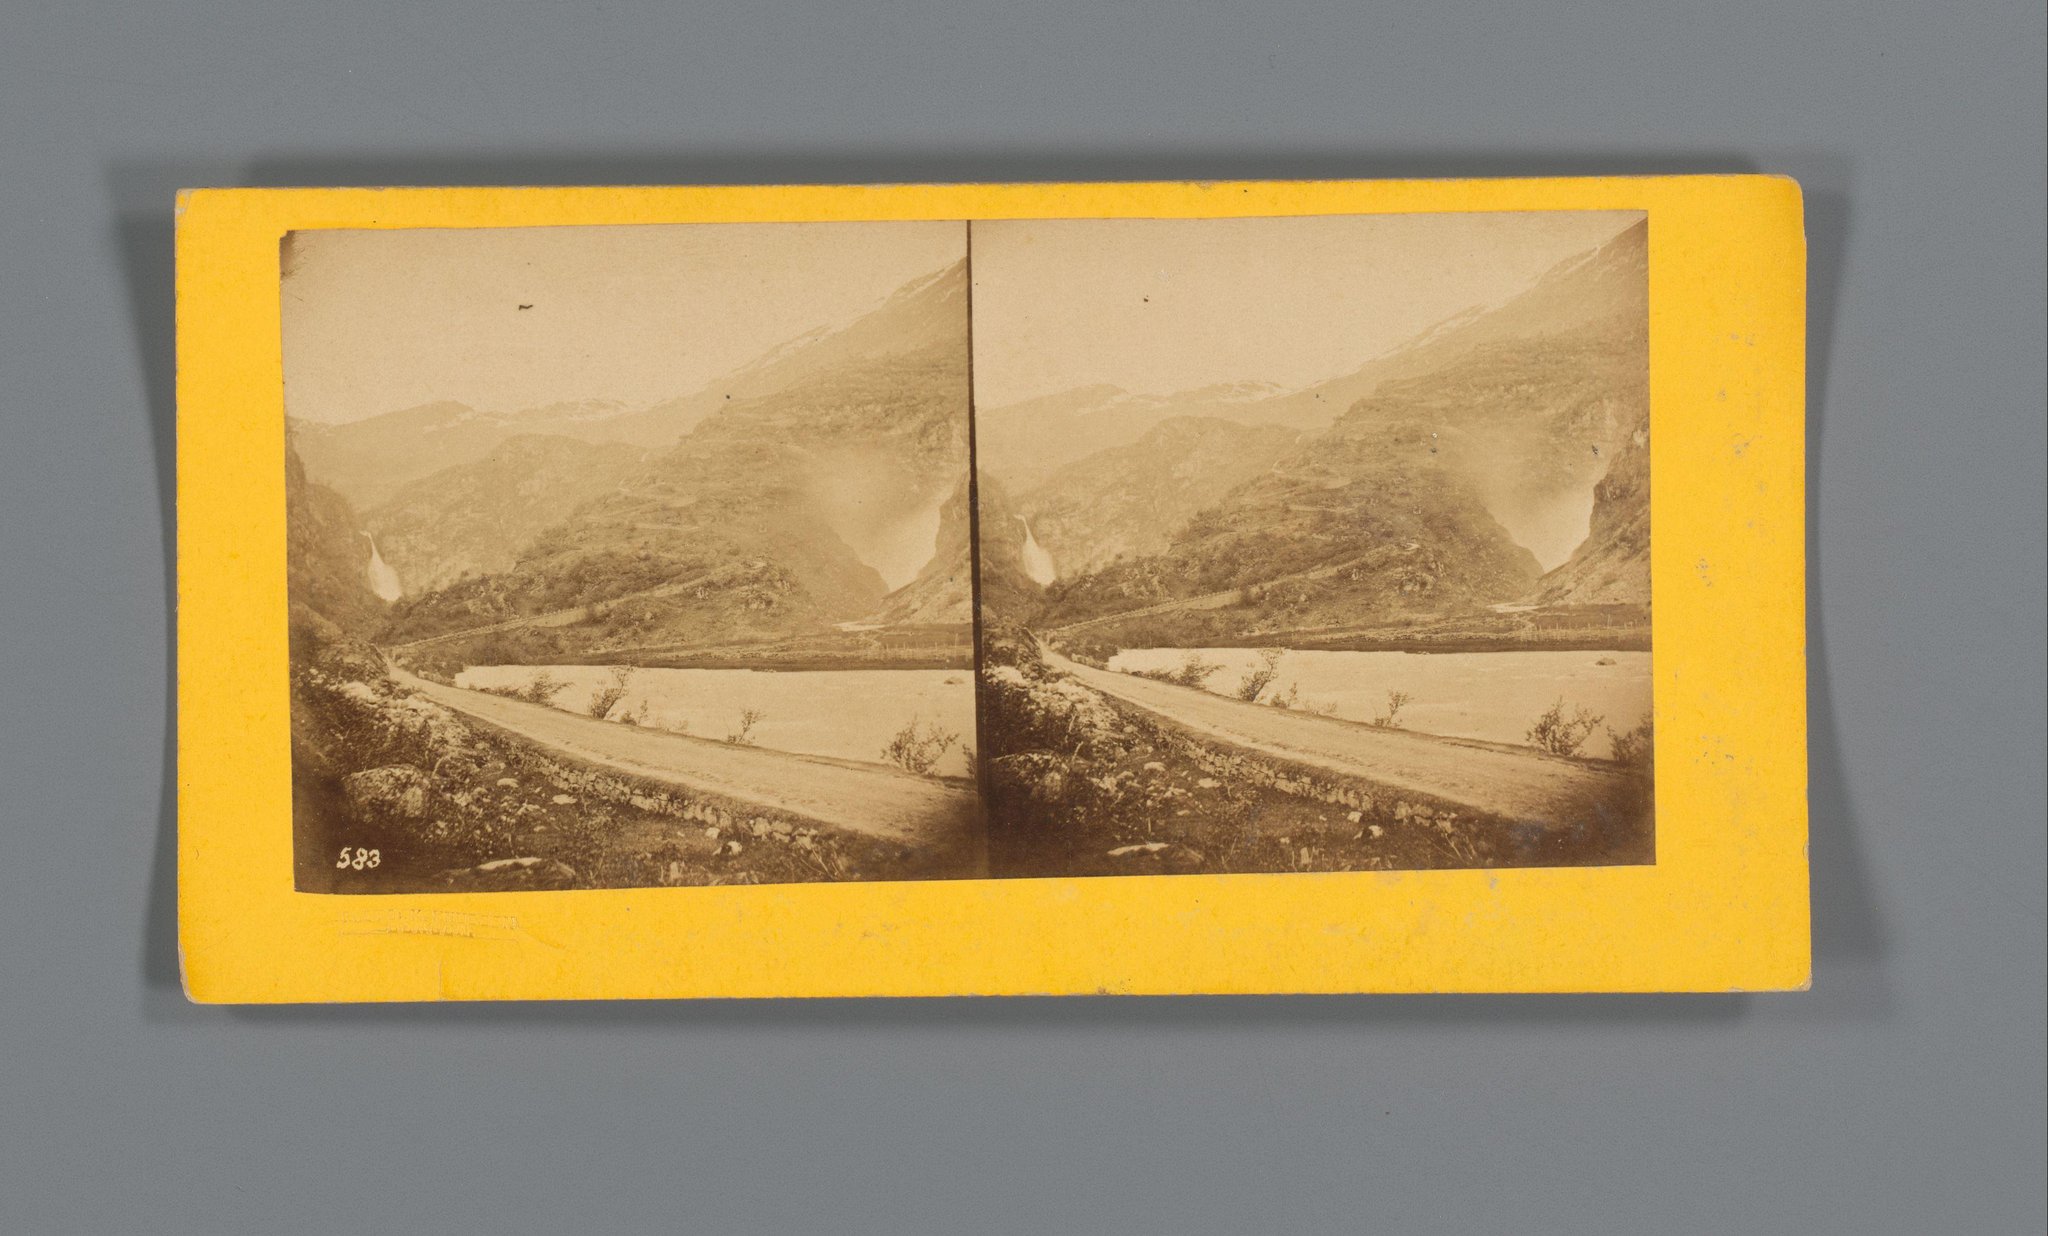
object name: stereograph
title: Gezicht op de omgeving van Stalheim, Noorwegen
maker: knud knudsen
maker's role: fotograaf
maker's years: 1832-1915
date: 1861-1870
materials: cardboard, paper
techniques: albumen print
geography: stalheim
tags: river, mountains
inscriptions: number: ‘583’